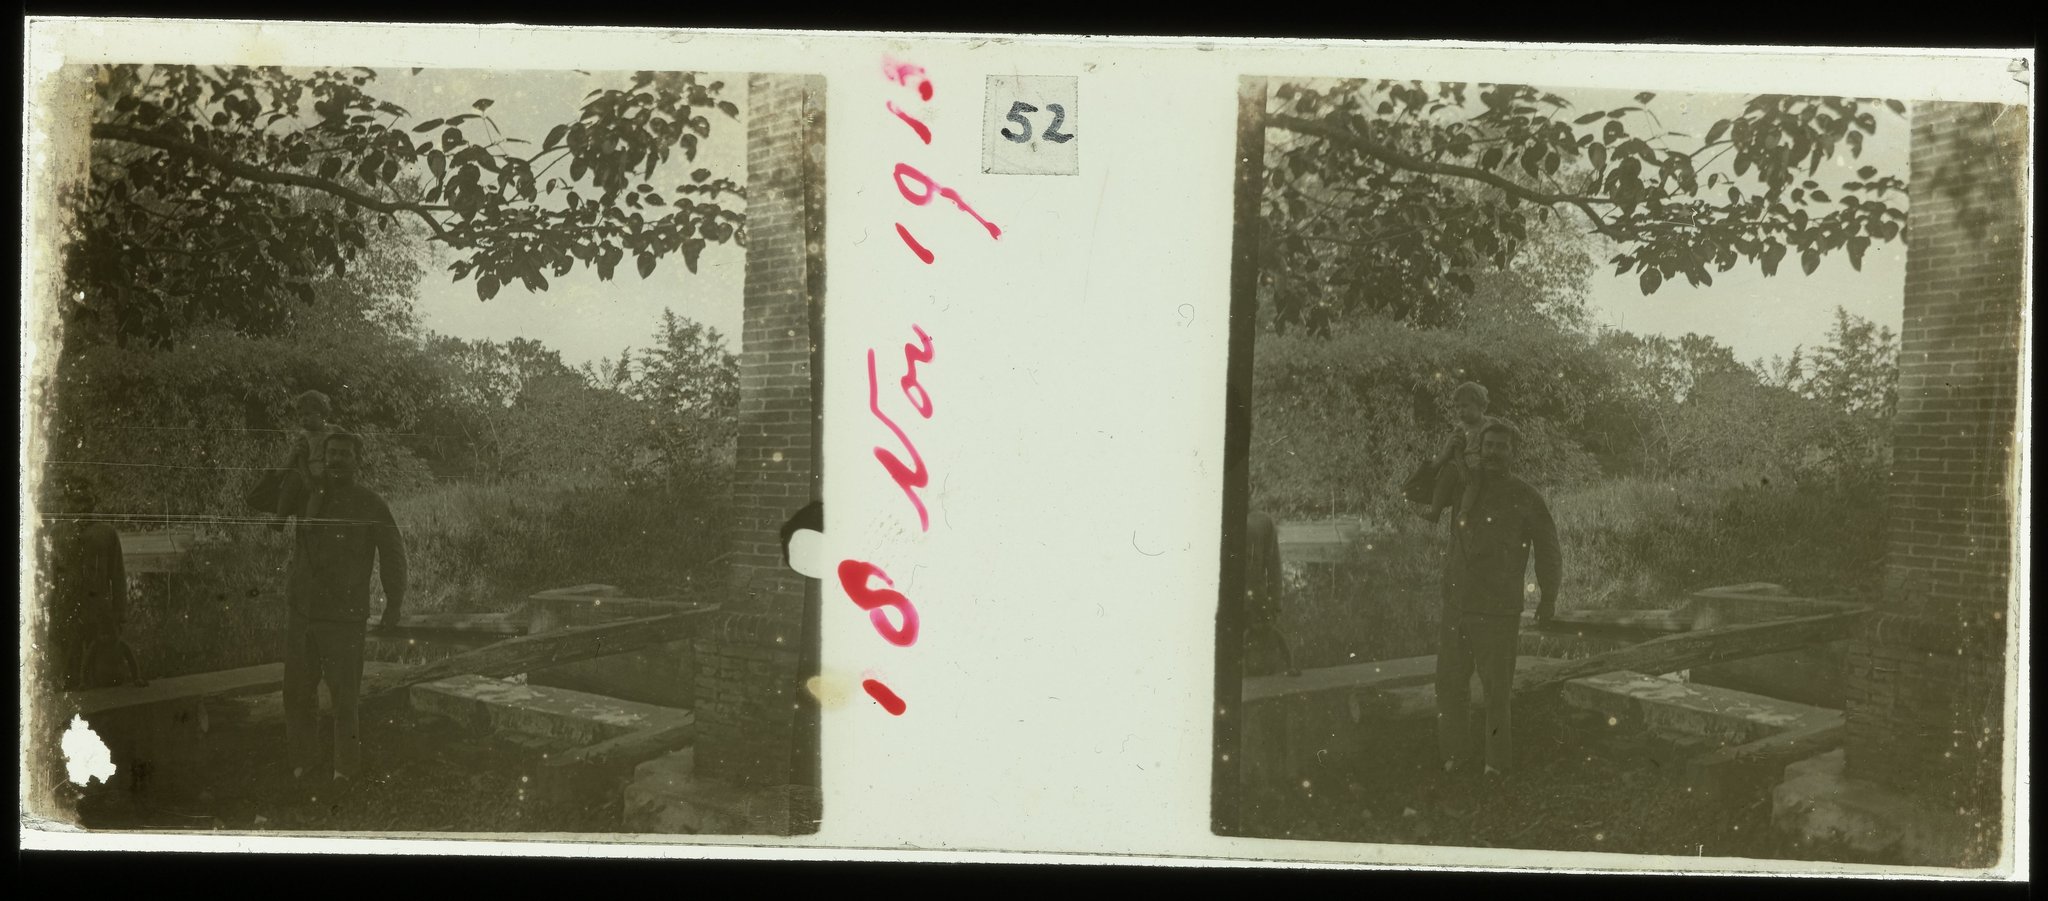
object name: stereograph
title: Plantage Accaribo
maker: Anonymous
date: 1913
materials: glass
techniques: photography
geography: suriname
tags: theodoor brouwers, plantation, suriname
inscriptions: date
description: In de periode 1911-1932 woonde op plantage Accaribo in Suriname de familie Brouwers van wie de foto's afkomstig zijn. Rond 1910 vond Theodoor Brouwers werk op plantage Accaribo. In 1929 werd hij eigenaar van de plantage. Op Accaribo werden in zijn tijd bananen geproduceerd en wat koffie.